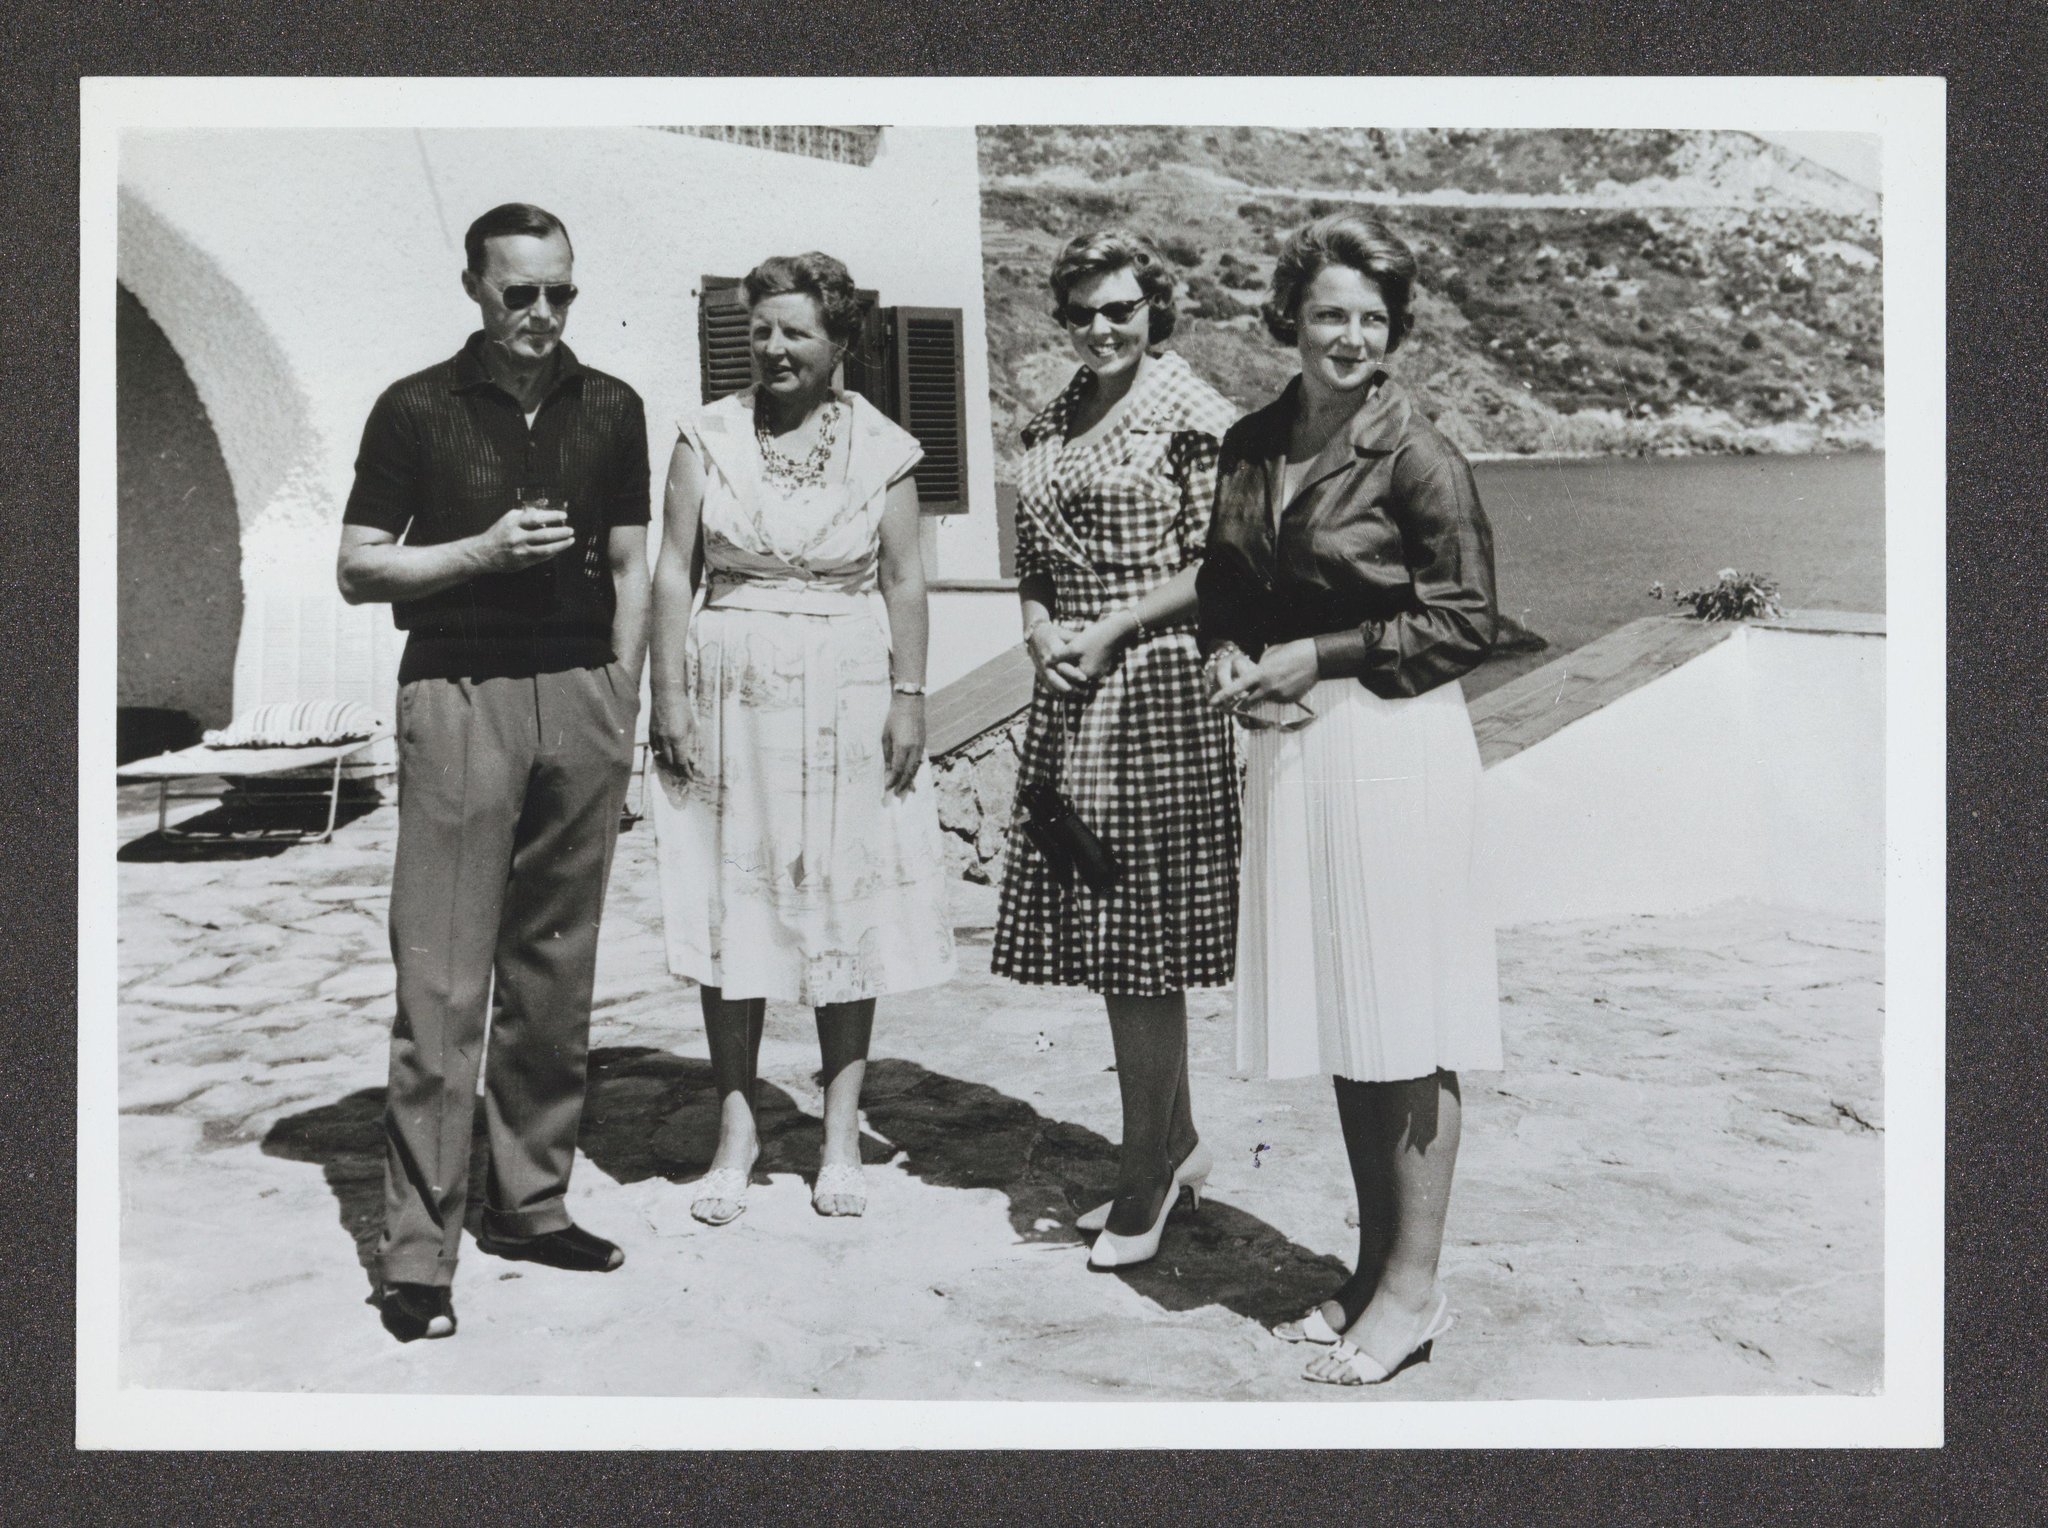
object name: photograph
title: Familieportret van Koningin Juliana, Prins Bernhard en Prinses Beatrix en Irene in Italië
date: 1960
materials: paper, photographic support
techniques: gelatin silver print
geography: netherlands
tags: bernhard (prins der nederlanden), beatrix (koningin der nederlanden), juliana of the netherlands, italy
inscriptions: inscription: ‘Queen Juliana... the olympic games in Rome’, signature: ‘COPYRIGHT / "ANEFO" / KERKSTRAAT 310 / AMSTERDAM-C. / TEL. 30744 33902 / No. [in potlood ingevuld: PRF131]’